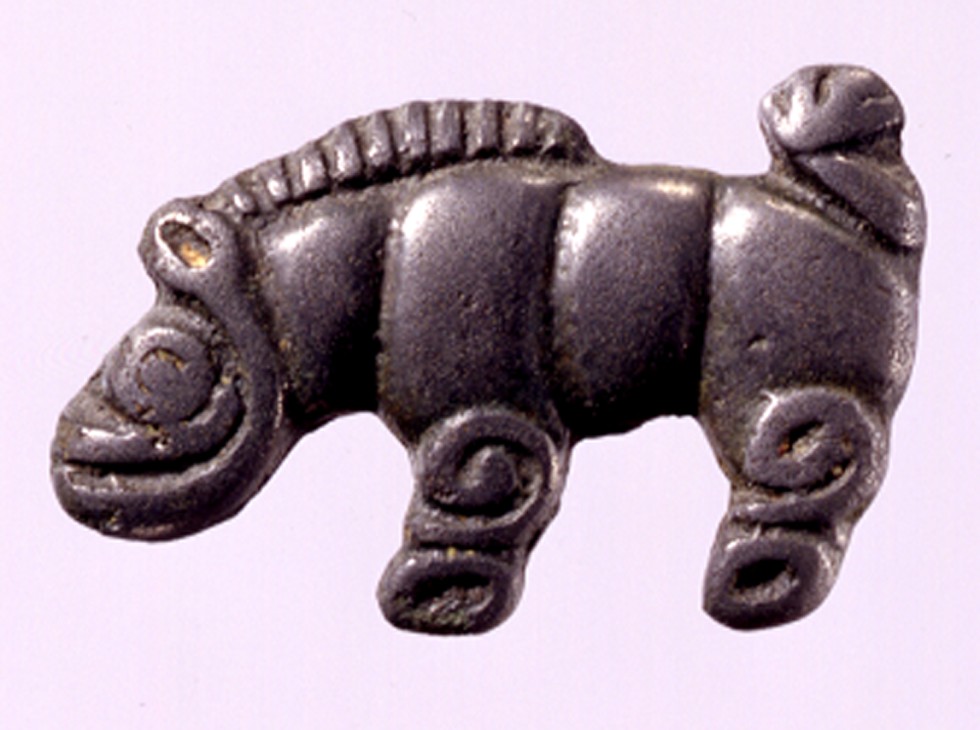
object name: garment plaque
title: Garment Plaque in the Shape of a Wild Boar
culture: northwest chinese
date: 500-301 BCE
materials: bronze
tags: boars